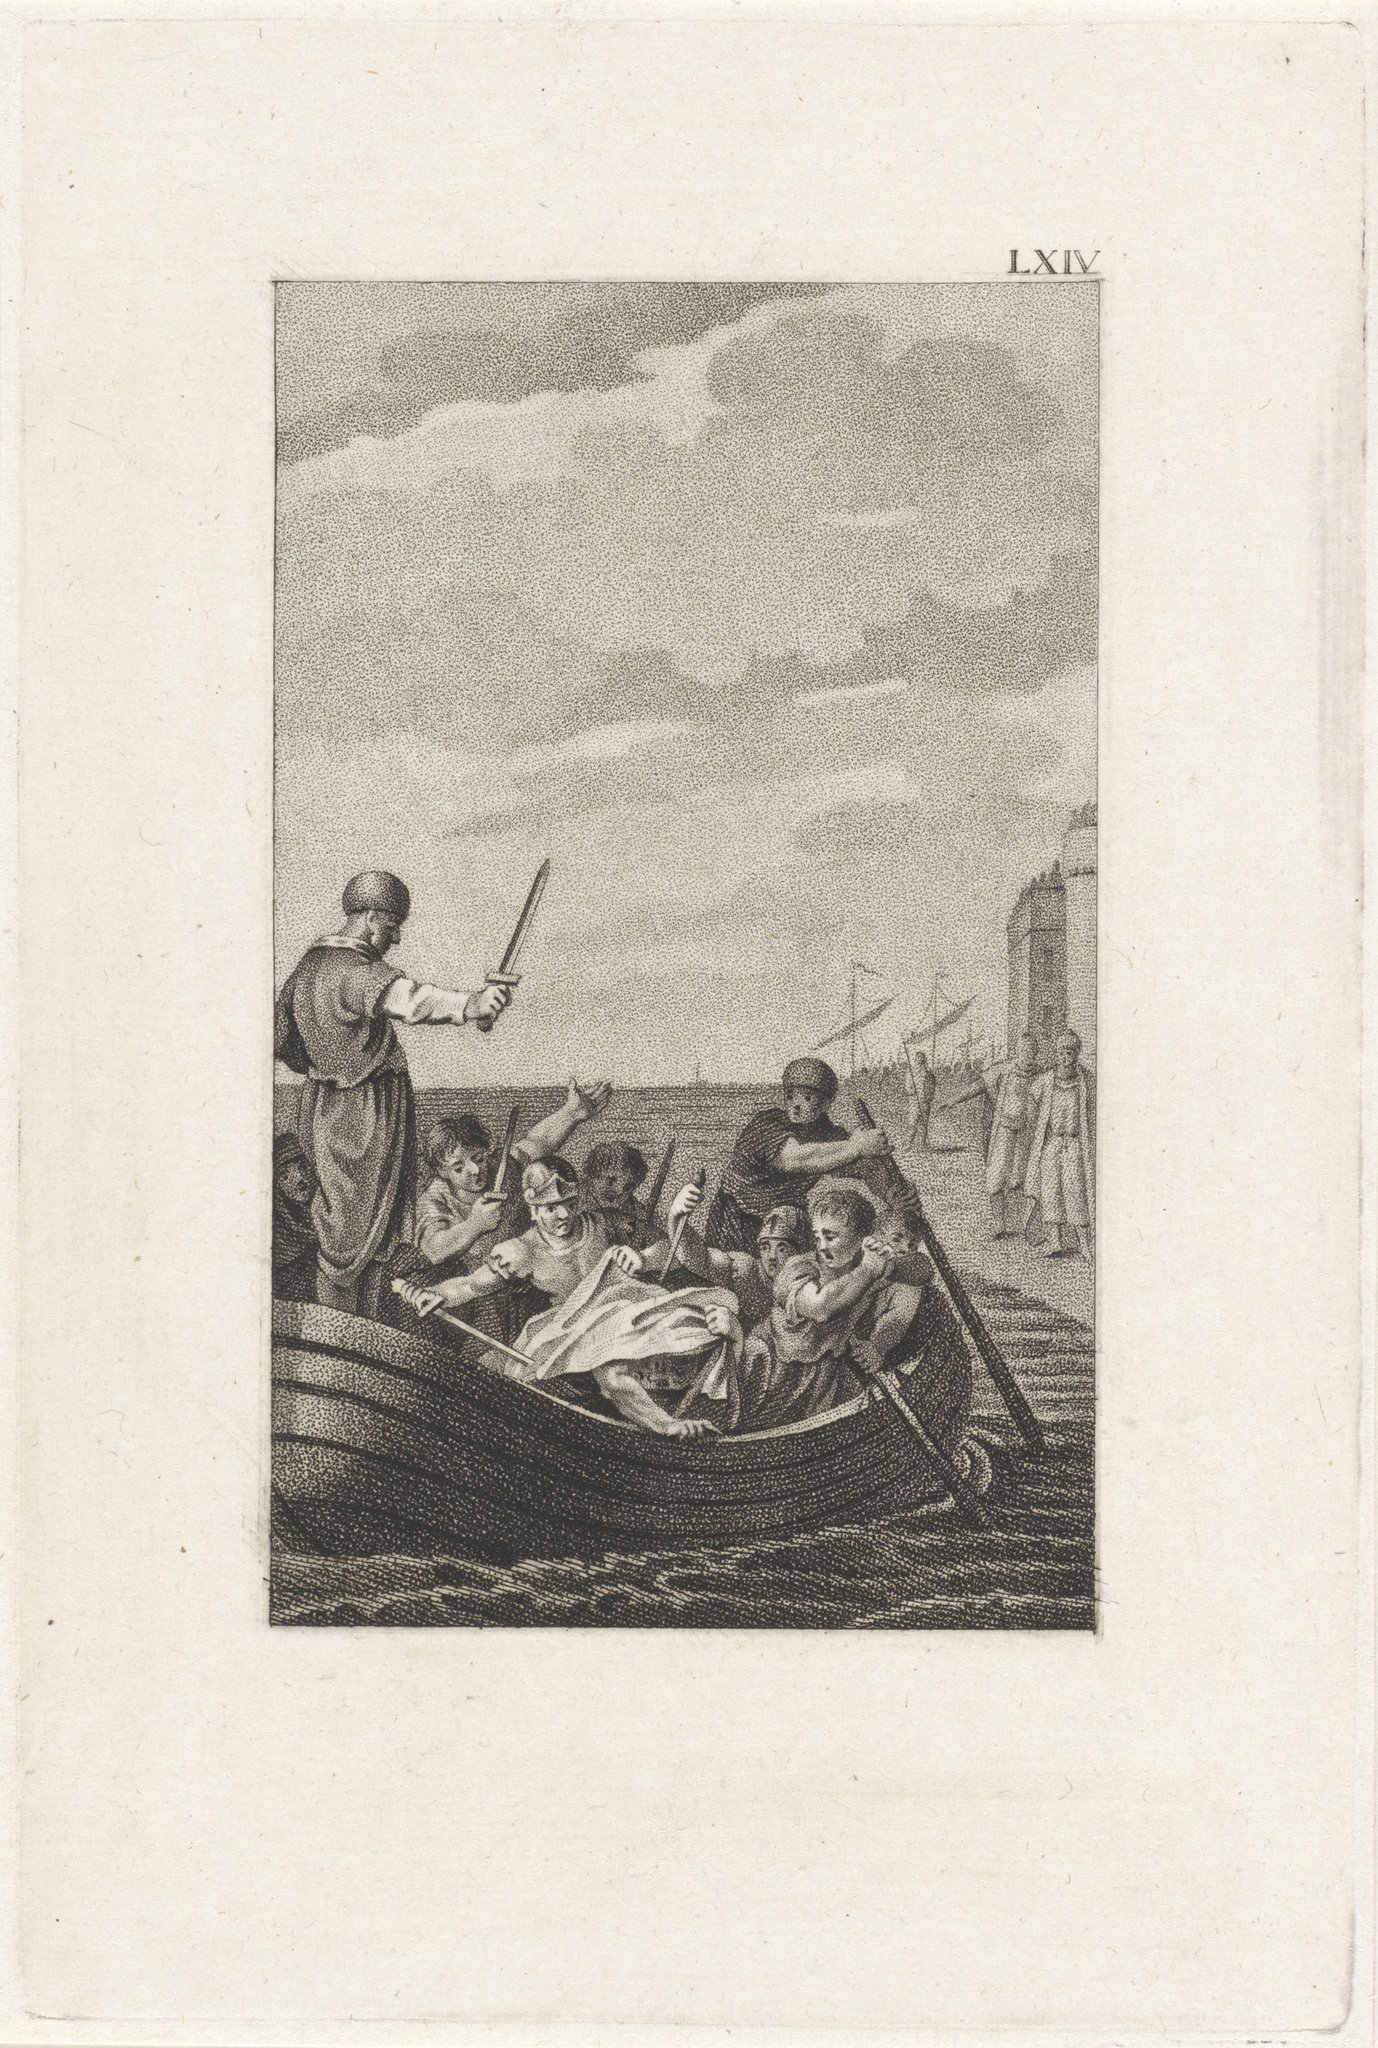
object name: print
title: Dood van Pompeius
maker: ludwig gottlieb portman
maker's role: print maker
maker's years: 1772-1828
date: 1800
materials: paper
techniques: etching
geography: amsterdam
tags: death of pompey: after leaving his galley, pompey is murdered in the boat sent to bring him ashore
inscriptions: collector's mark: Lugt 2228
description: In de boot die hem aan land zou brengen wordt Pompeius in de rug gestoken door Septimius. Ook Salvius en Achilles trekken hun dolk. Pompeius is machteloos en trekt zijn gewaad over zijn hoofd.